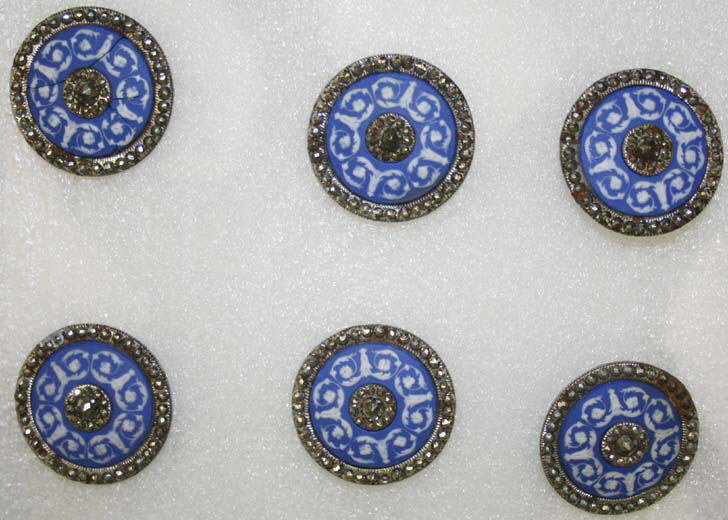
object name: button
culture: european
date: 1775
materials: jasper, metal